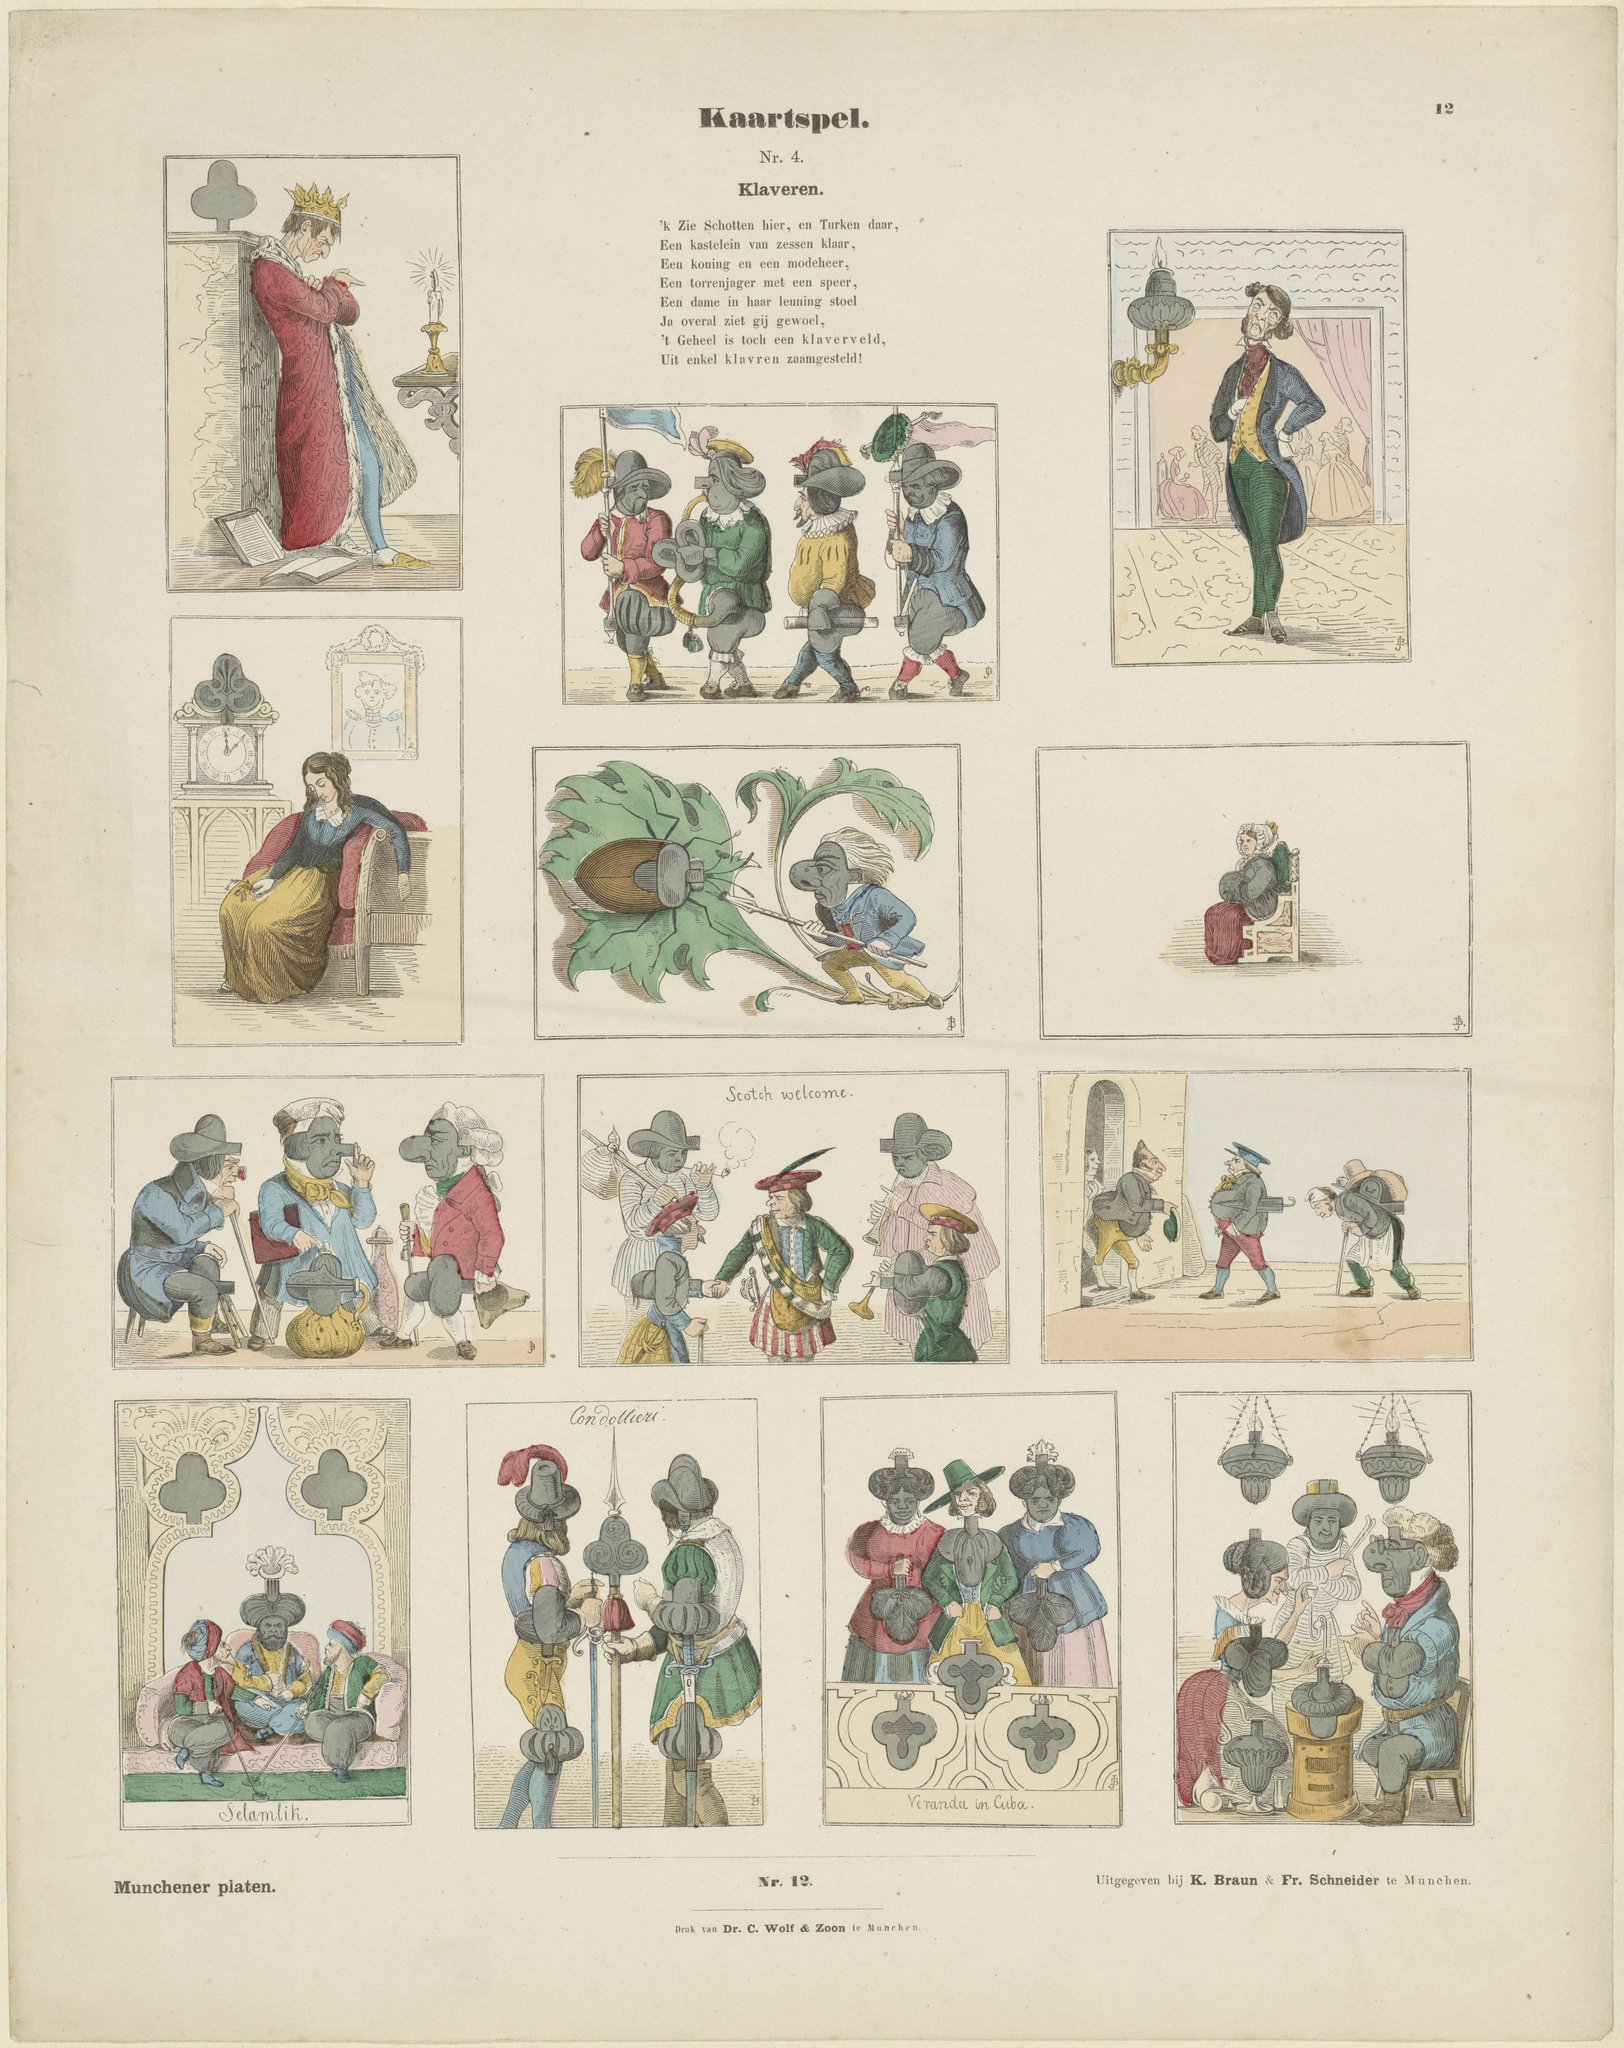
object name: print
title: Kaartspel. / Nr. 4. / Klaveren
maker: j. beeg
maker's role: draughtsman, print maker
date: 1843-1920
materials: paper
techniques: colour, letterpress printing, engraving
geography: munich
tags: playing-cards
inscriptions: collector's mark: Lugt 2760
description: Blad met 13 voorstellingen van speelkaarten (klaveren), met verschillende figuren. Onder de titel een achtregelig vers. Genummerd midden onder: Nr. 12. Genummerd rechtsboven: 12.